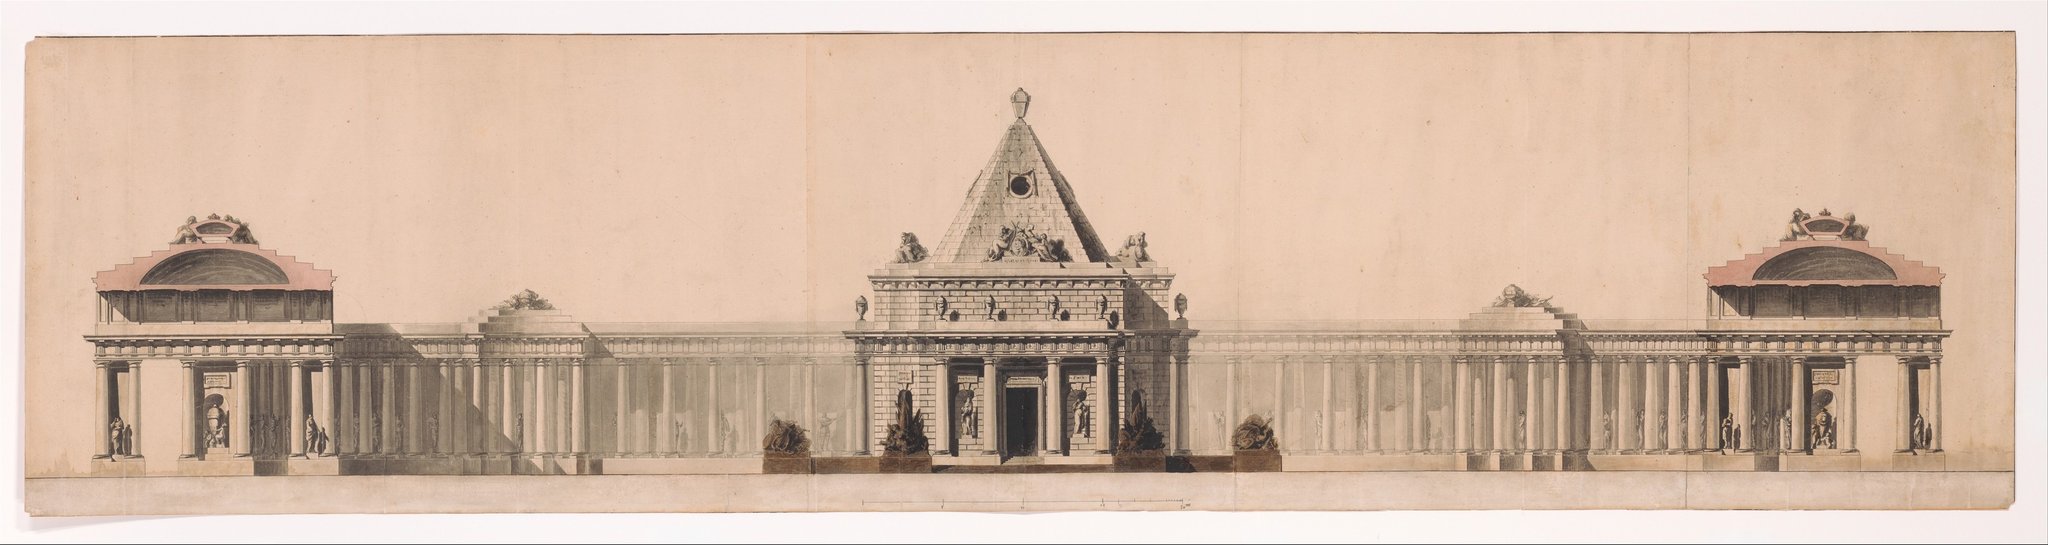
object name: drawing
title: Elevation of a Monument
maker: jean jacques huvé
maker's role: artist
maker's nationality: french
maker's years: 1742-1808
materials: graphite, ink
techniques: brush, pen, wash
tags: architecture,monuments